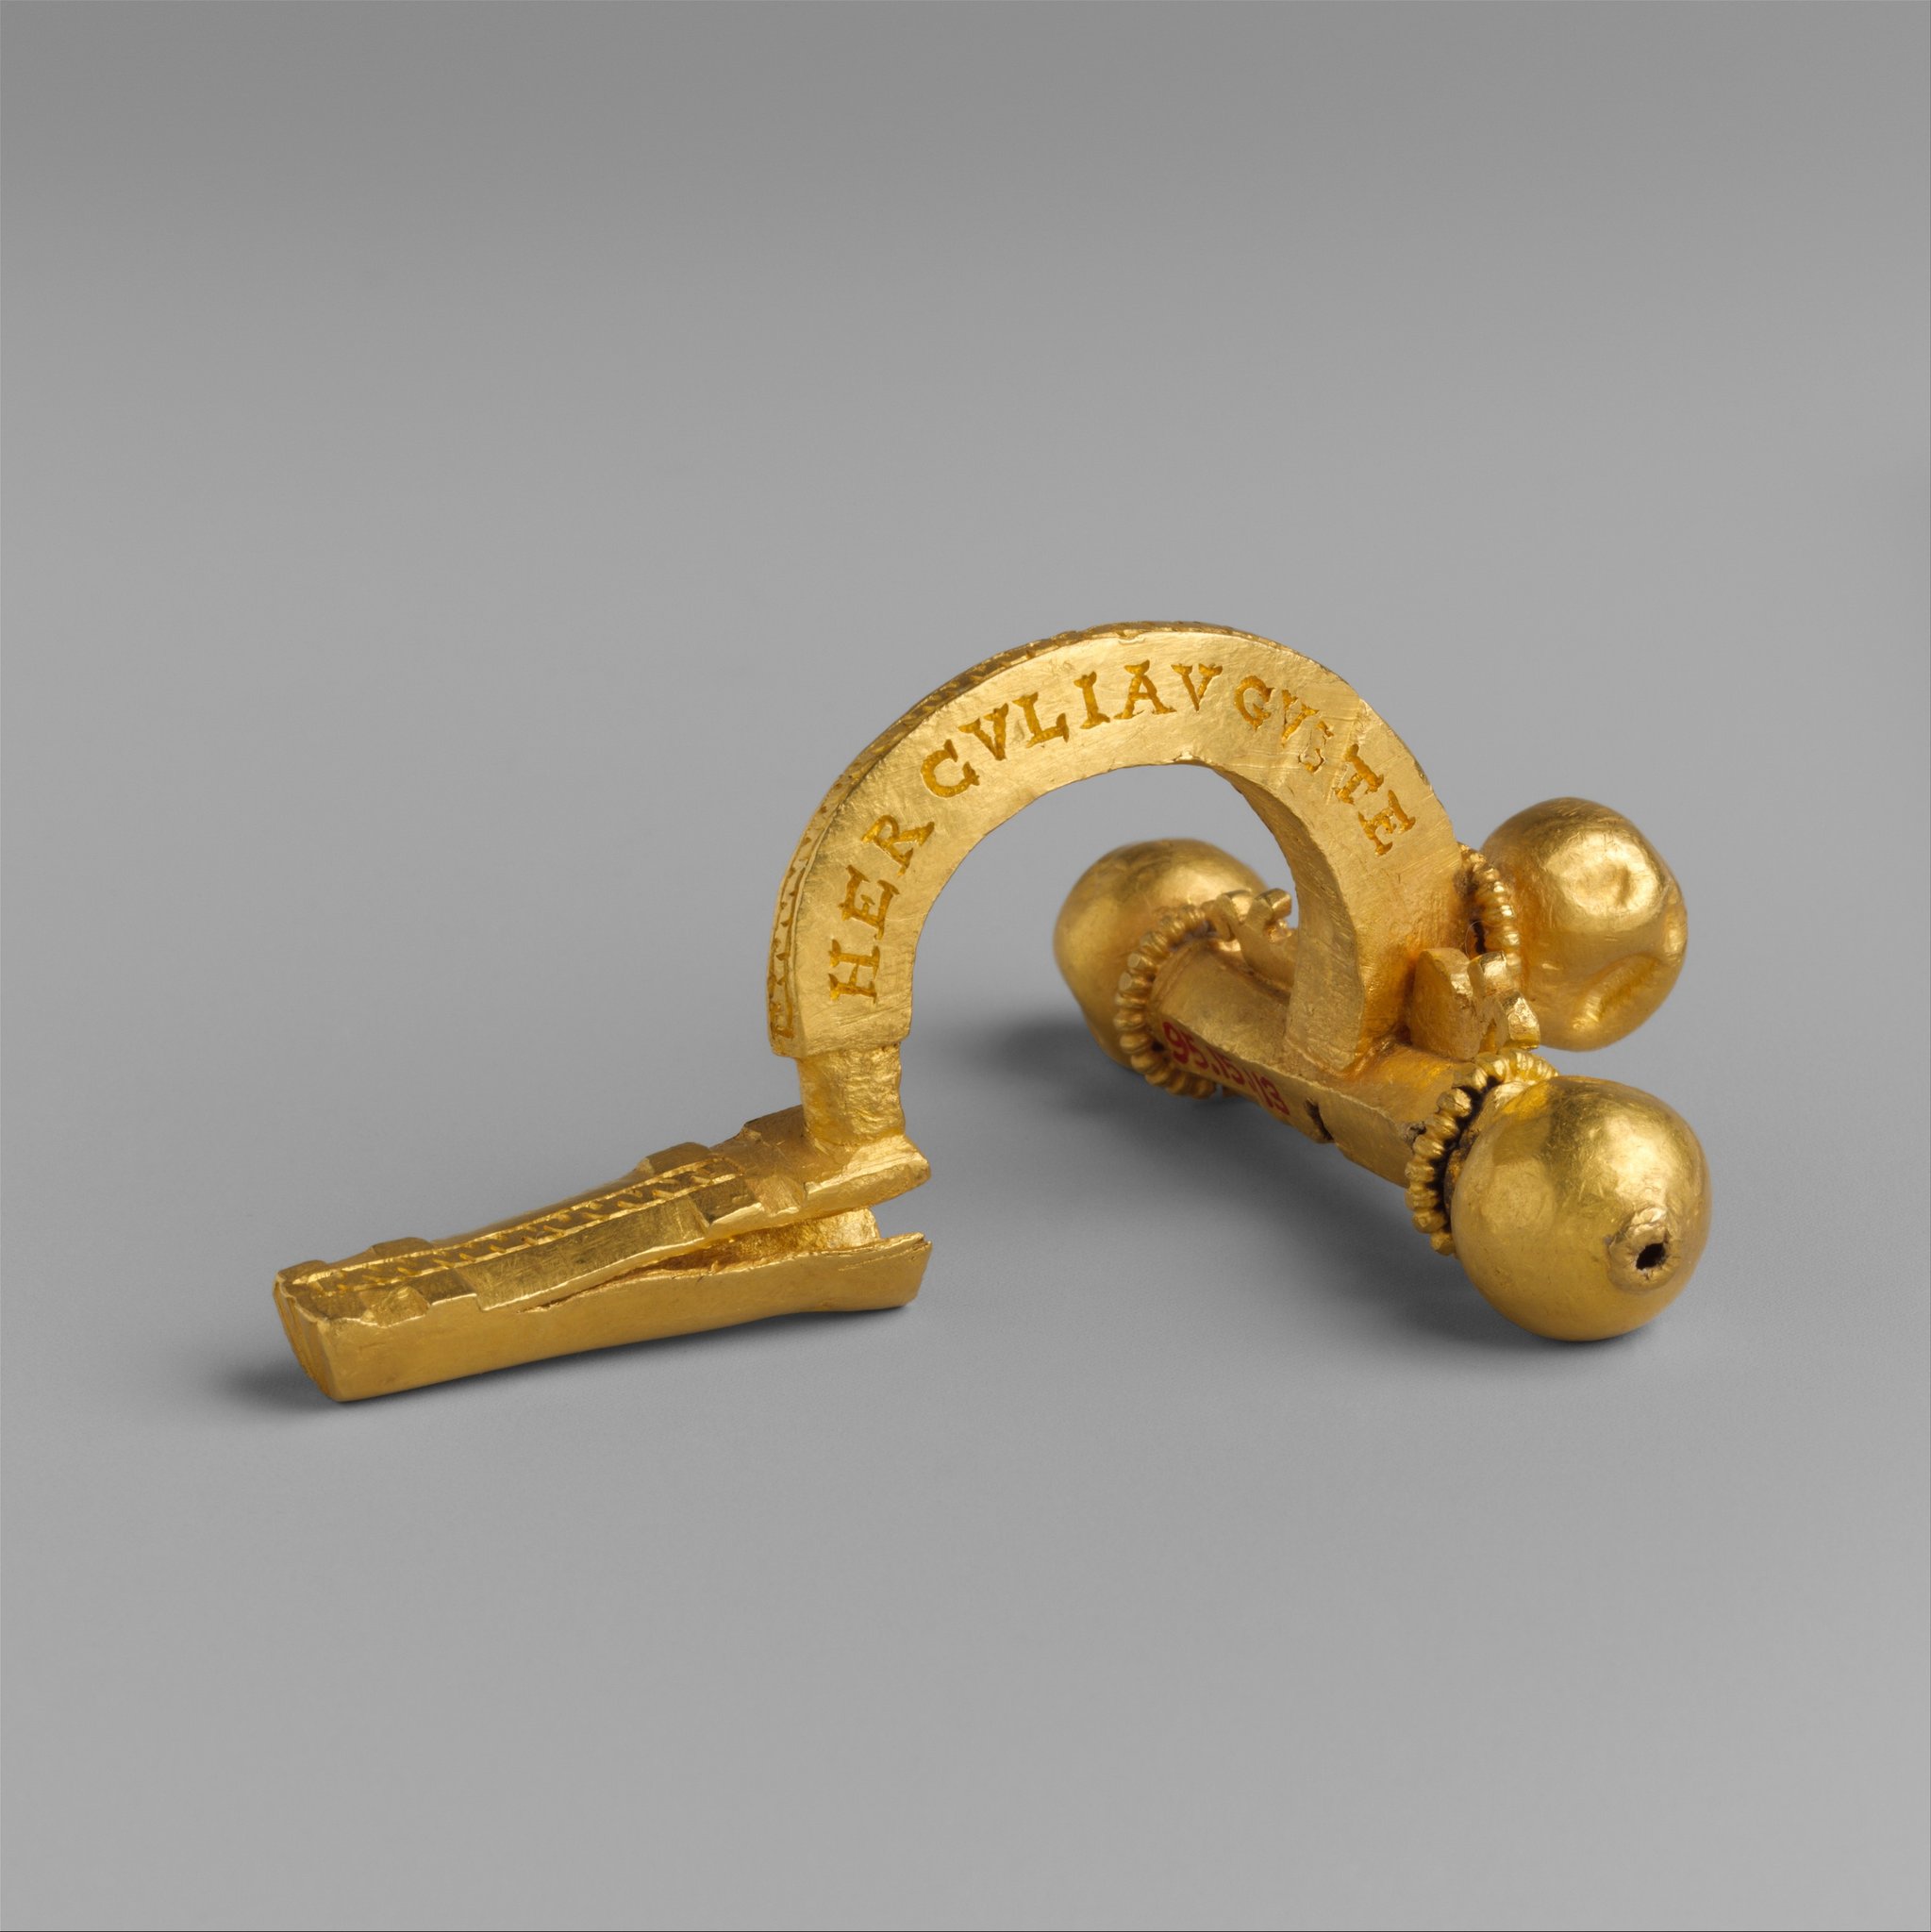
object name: fibula, crossbow type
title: Gold crossbow fibula (brooch)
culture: roman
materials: gold